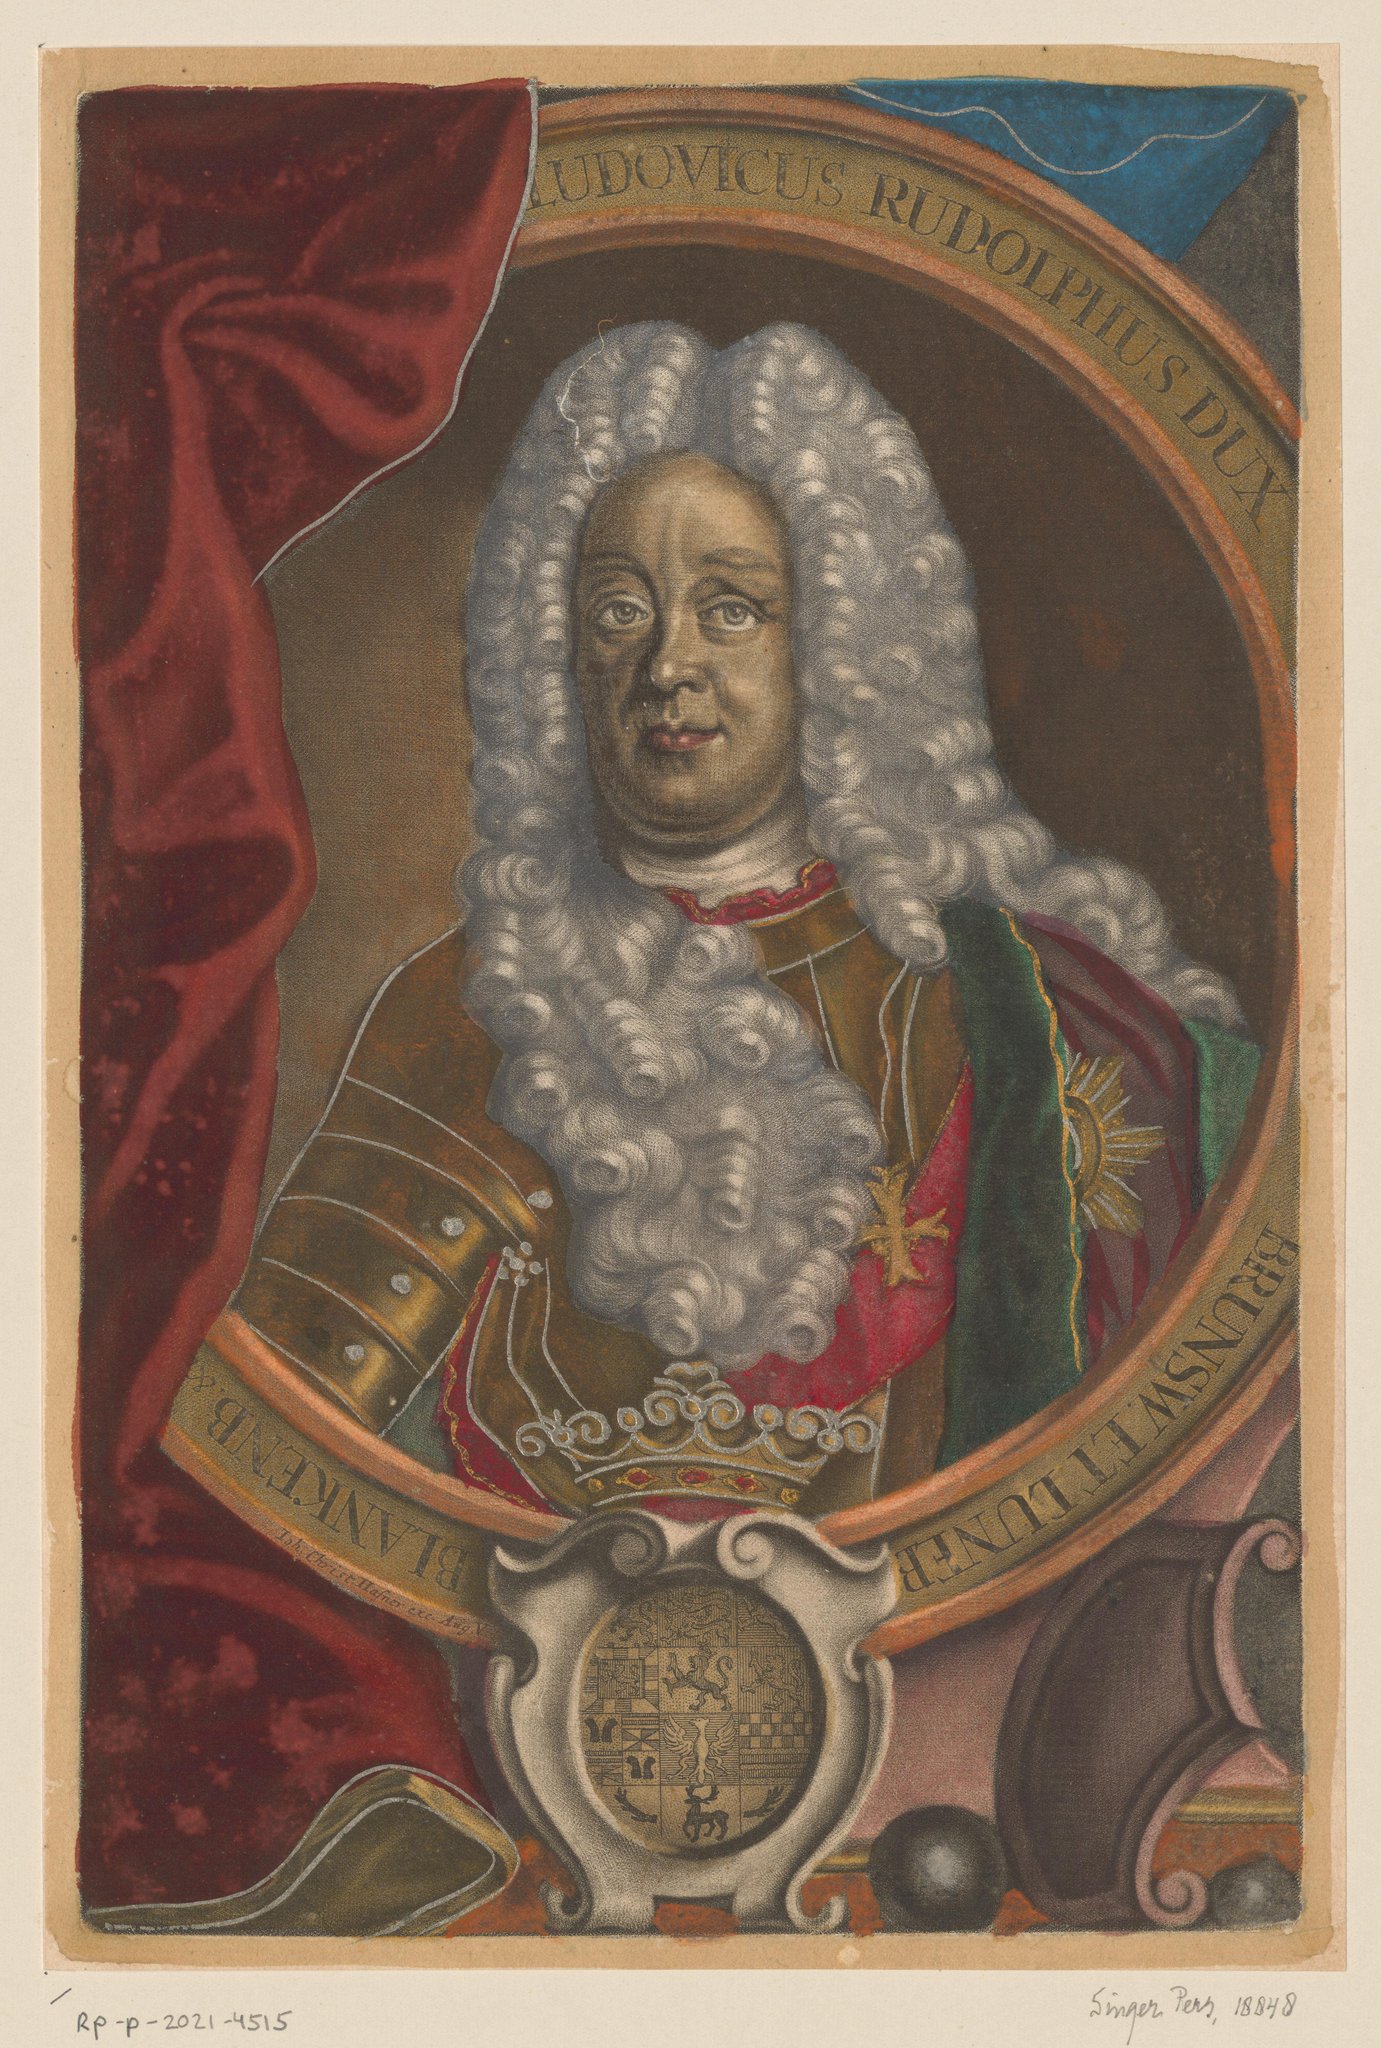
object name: print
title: Portret van Lodewijk Rudolf van Brunswijk-Wolfenbüttel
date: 1731-1754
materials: paper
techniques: etching, hand coloring, roulette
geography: germany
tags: (feigned) picture curtain, ornament ~ medallion, armour, historical persons, armorial bearing, heraldry